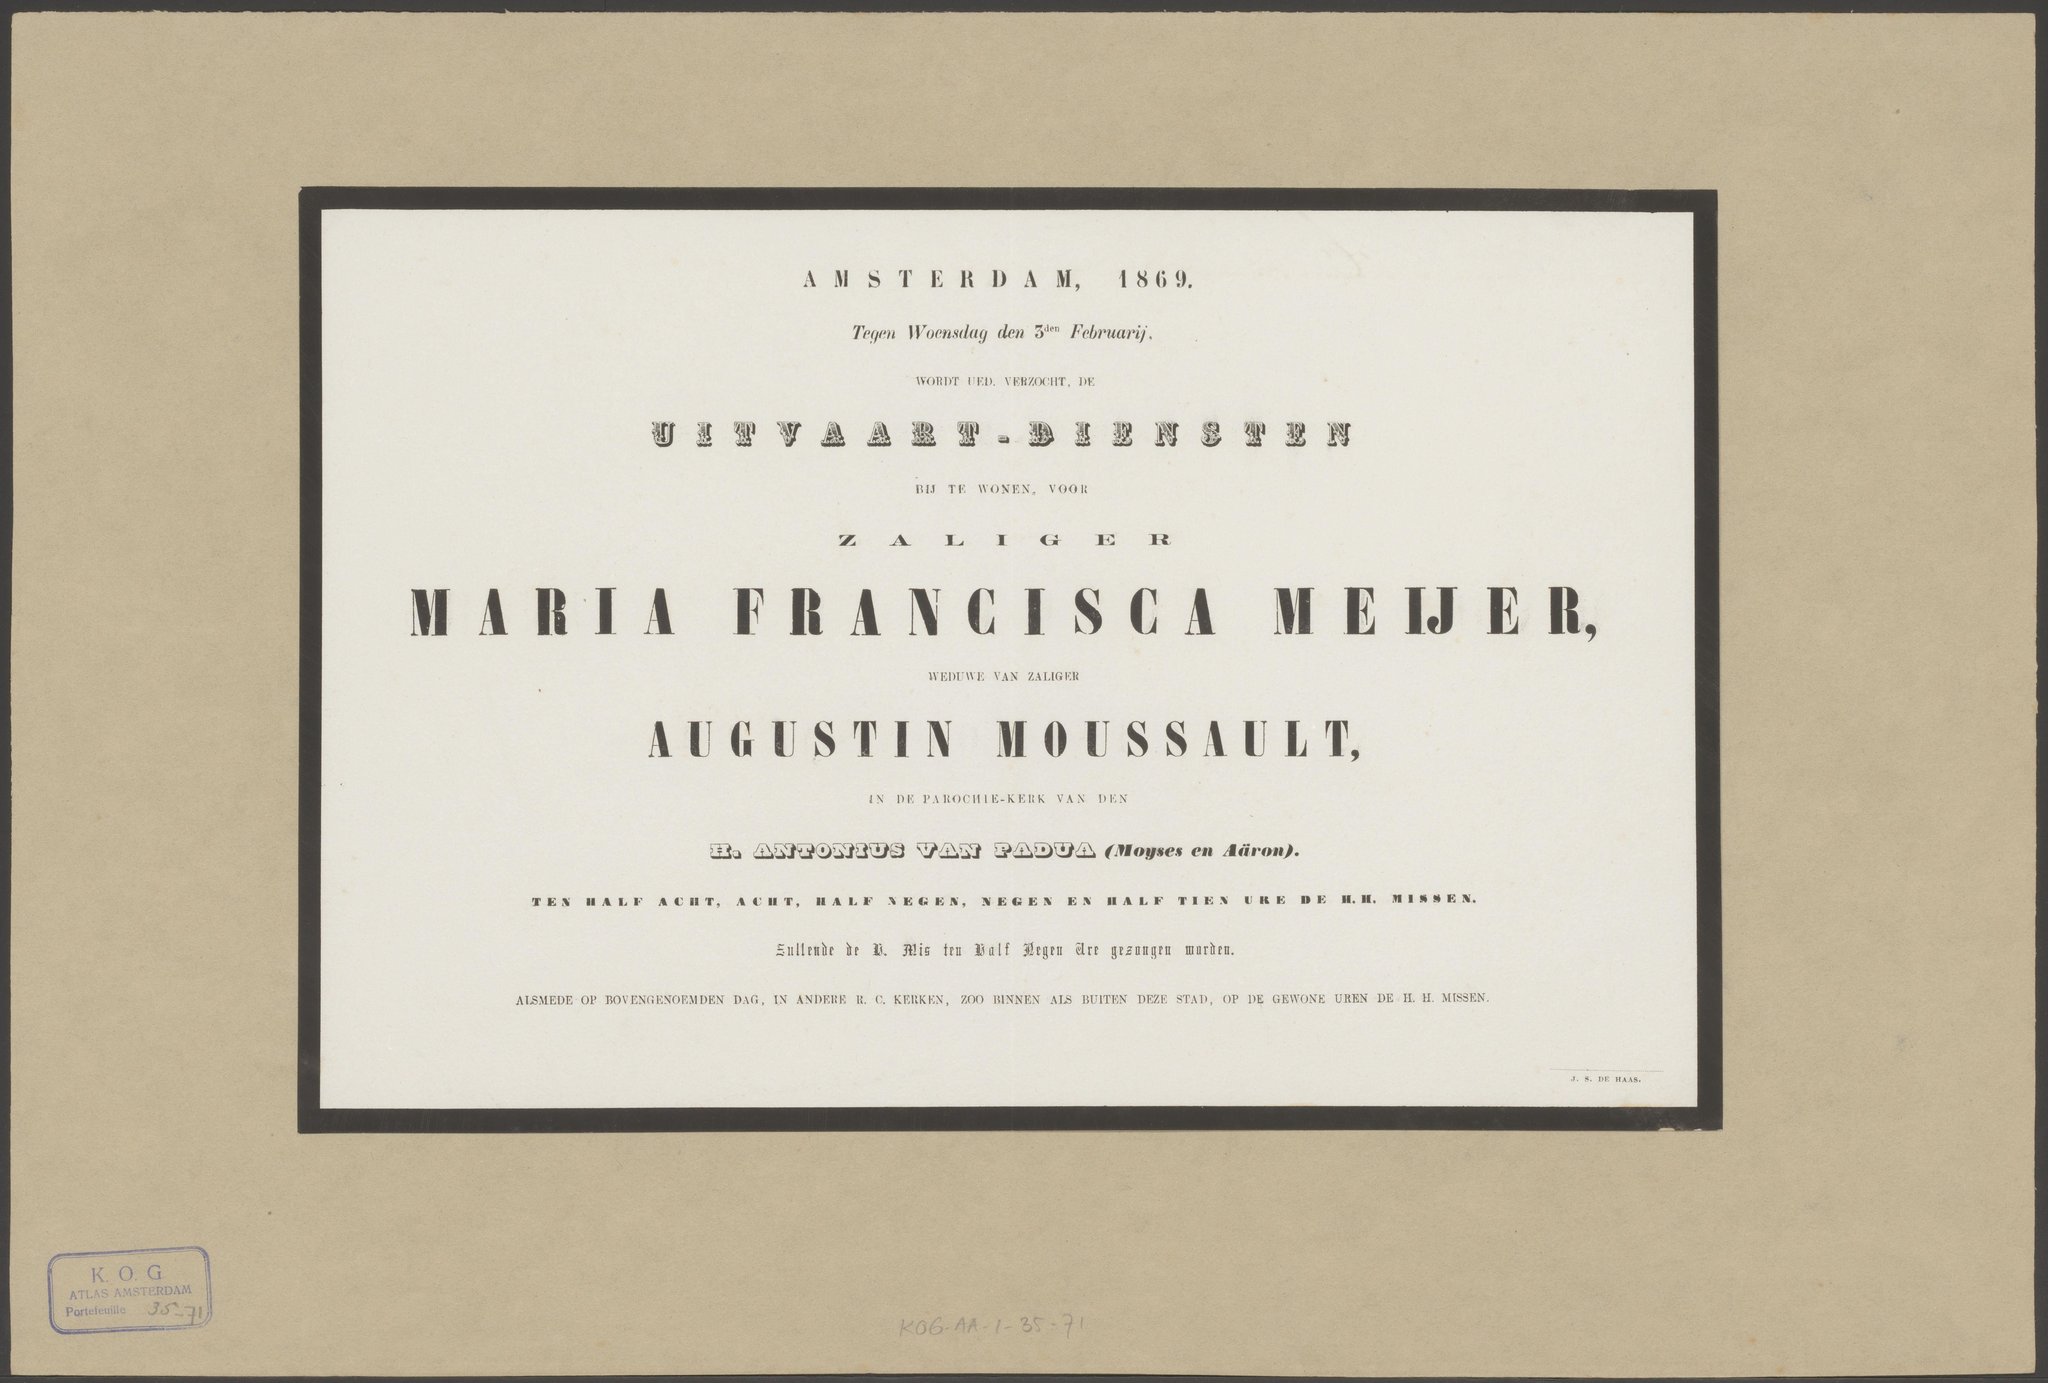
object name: text sheet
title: Aankondiging van de uitvaart van Maria Francisca Meijer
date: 1869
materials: paper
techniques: letterpress printing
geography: amsterdam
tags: announcement of death, public funeral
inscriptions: collector's mark: ‘35-71’ Lugt 1641b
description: Onderwerpsrubriek binnen de Atlas Amsterdam: R.K. Gemeenten: Herinneringen aan pastoors.